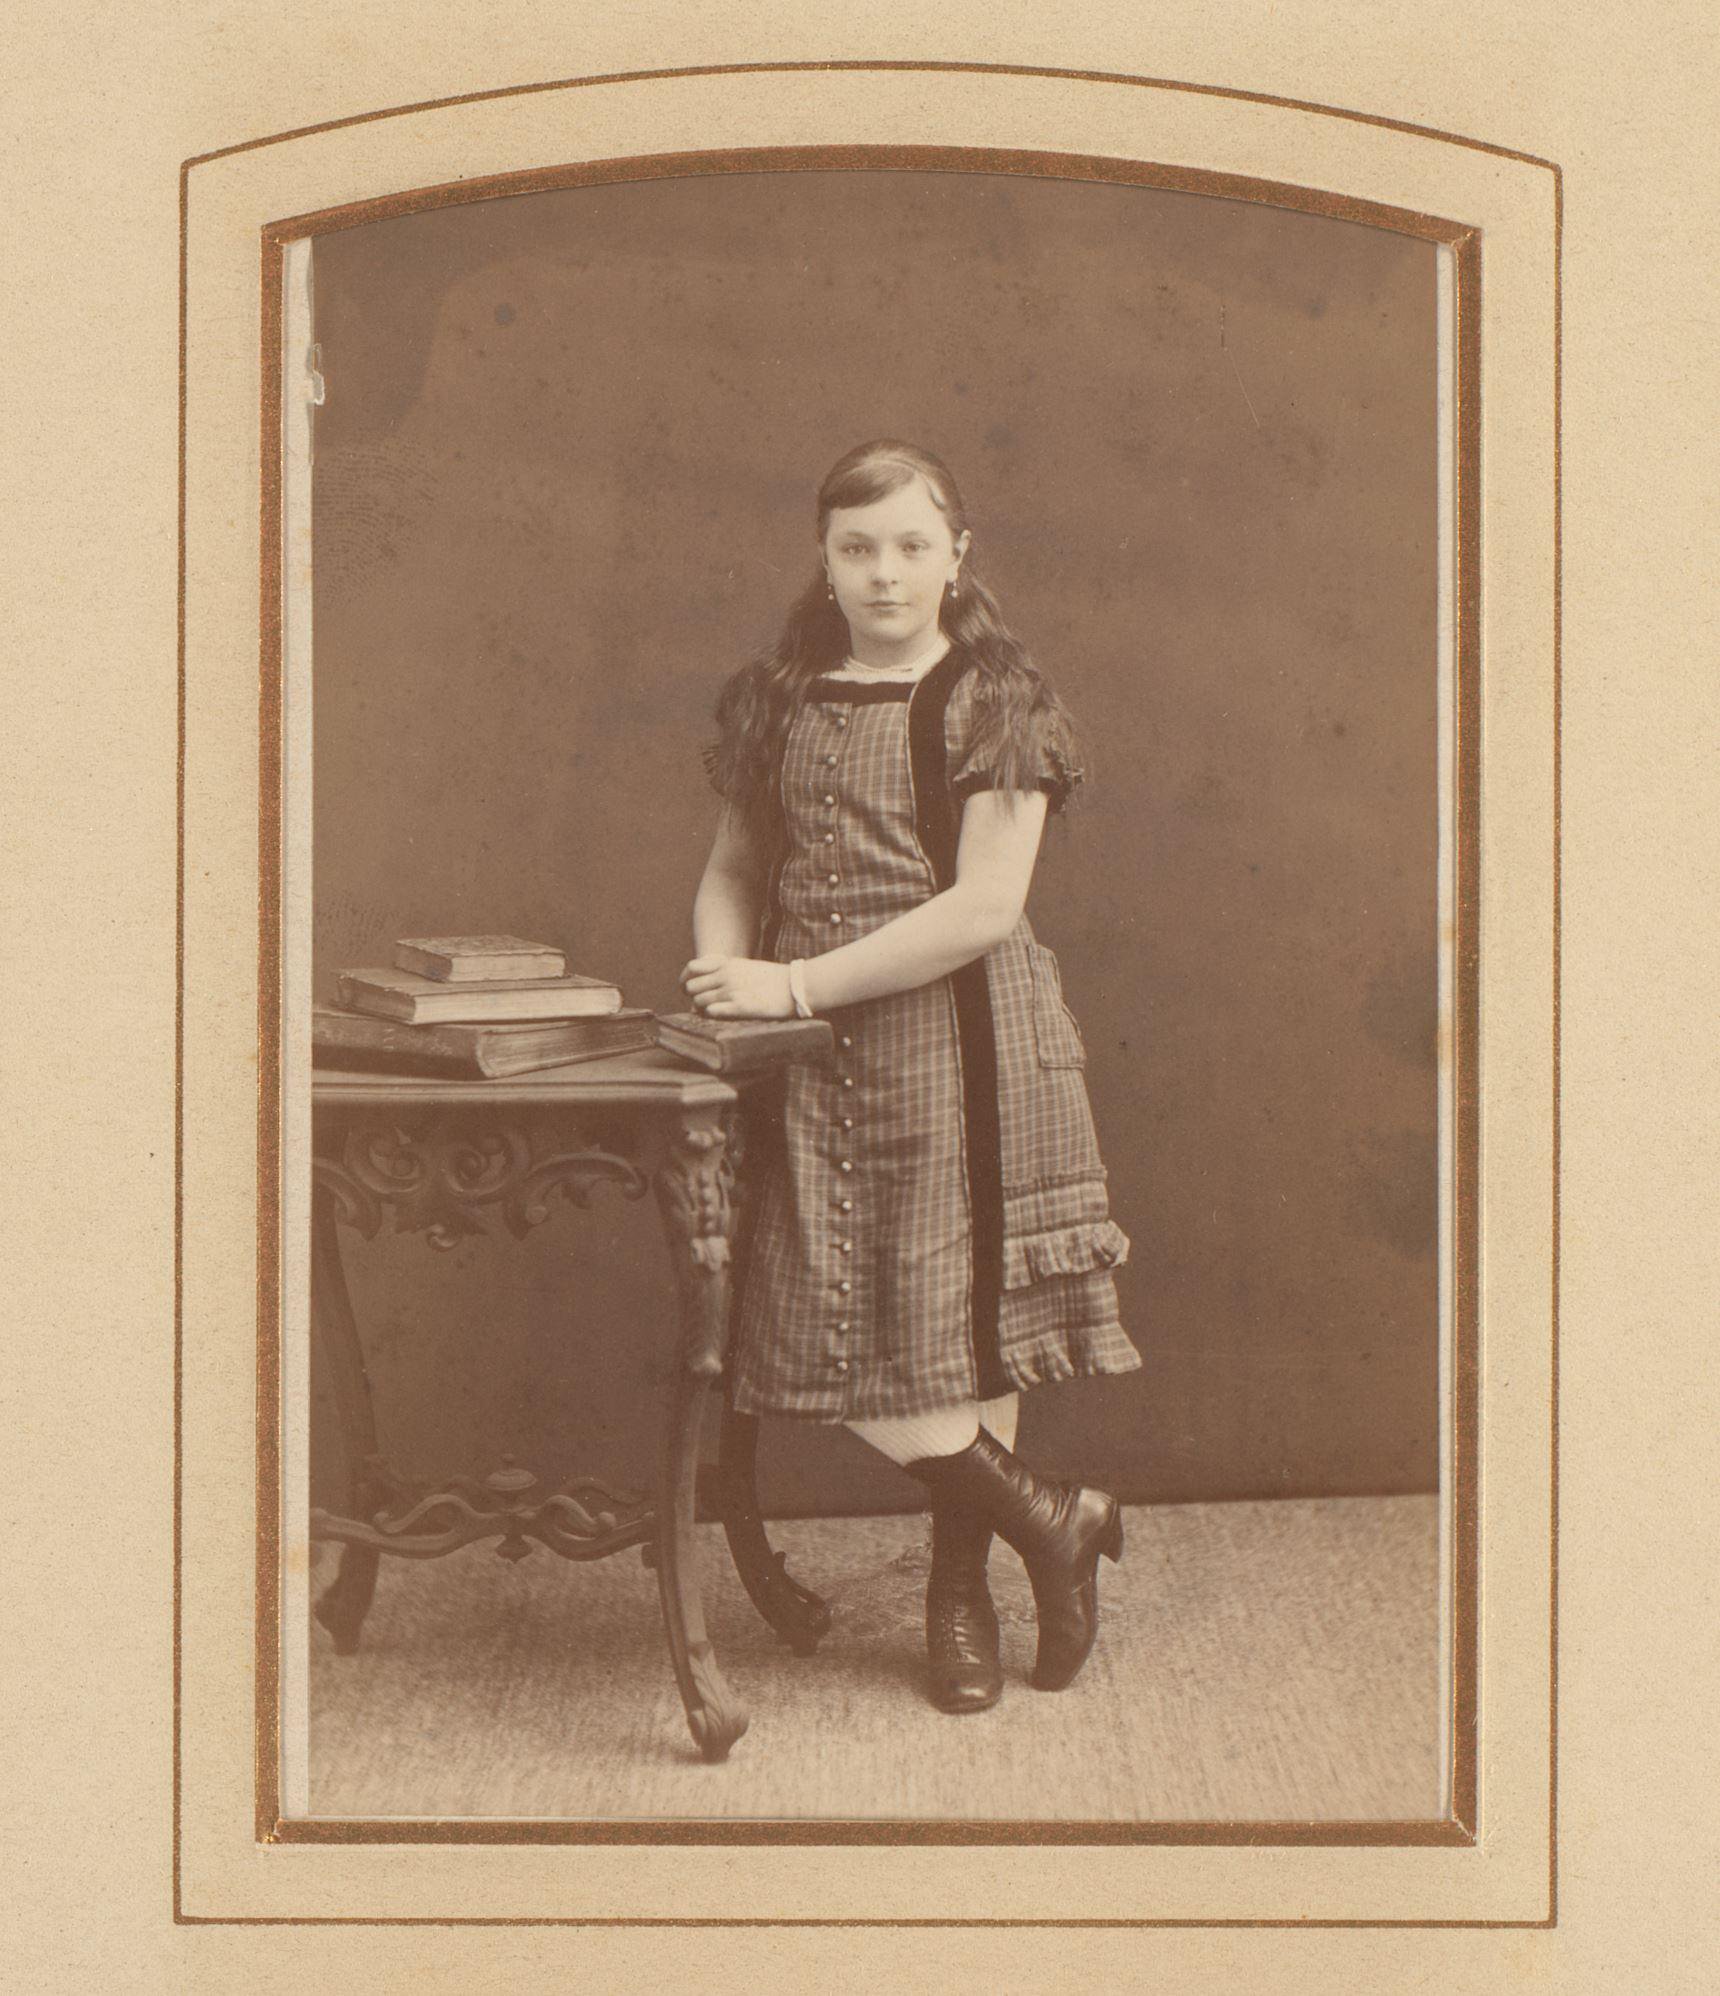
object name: cabinet photograph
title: Portret van een meisje, staand bij een bureau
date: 1865-1903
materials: cardboard, photographic support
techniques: albumen print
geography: the hague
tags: girl (child between toddler and youth)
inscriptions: inscription: ‘De Lavieter & Co./ La Haye’, inscription: ‘De Lavieter & Co./ Photographes de S.M. le Roi/ Et de son altesse Royale/ Le Prince Alexandre/ Des Pays-Bas/ La Haye’